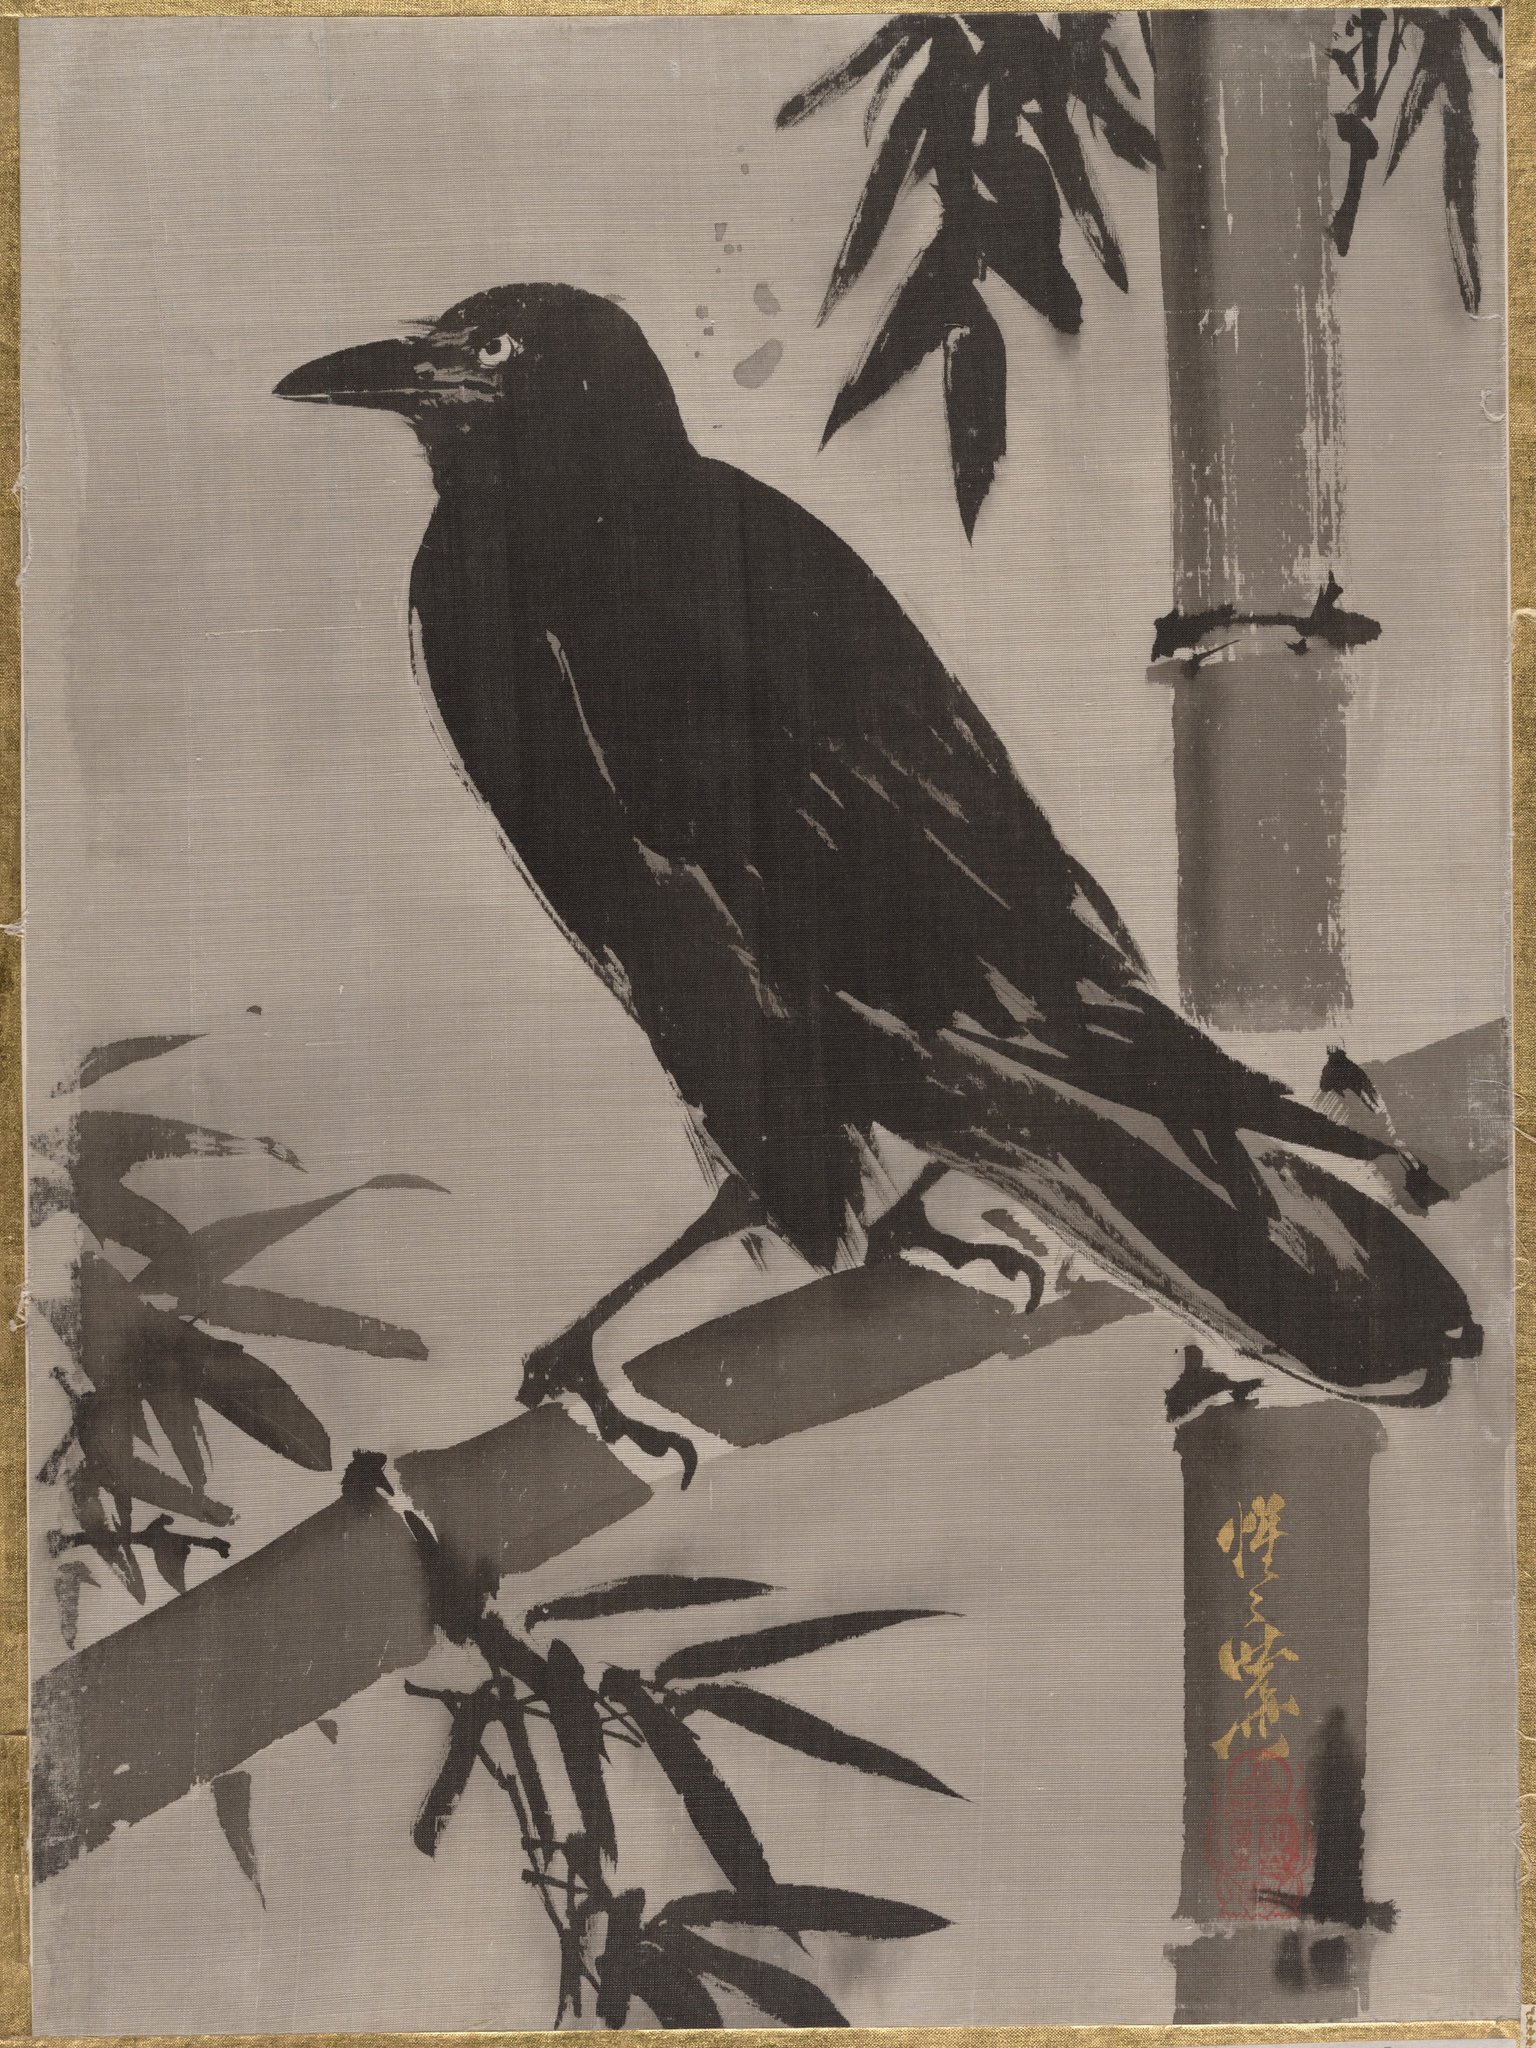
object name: album leaf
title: Crow on a Bamboo Branch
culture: japanese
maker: kawanabe kyōsai 河鍋暁斎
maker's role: artist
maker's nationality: japanese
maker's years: 1831-1889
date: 1887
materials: ink, silk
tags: birds,bamboo